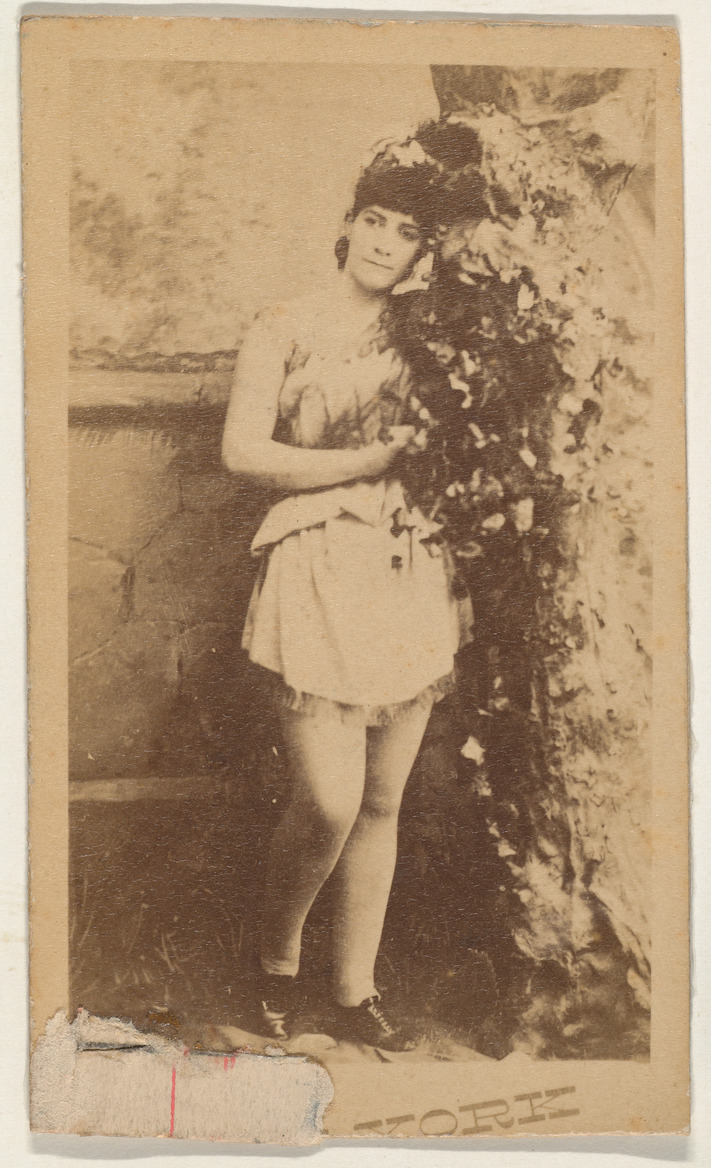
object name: photograph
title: Actress leaning on ivy-covered prop tree, from the series Actresses (N674), promoting New York Dandies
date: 1888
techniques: albumen silver print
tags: portraits,women,actresses